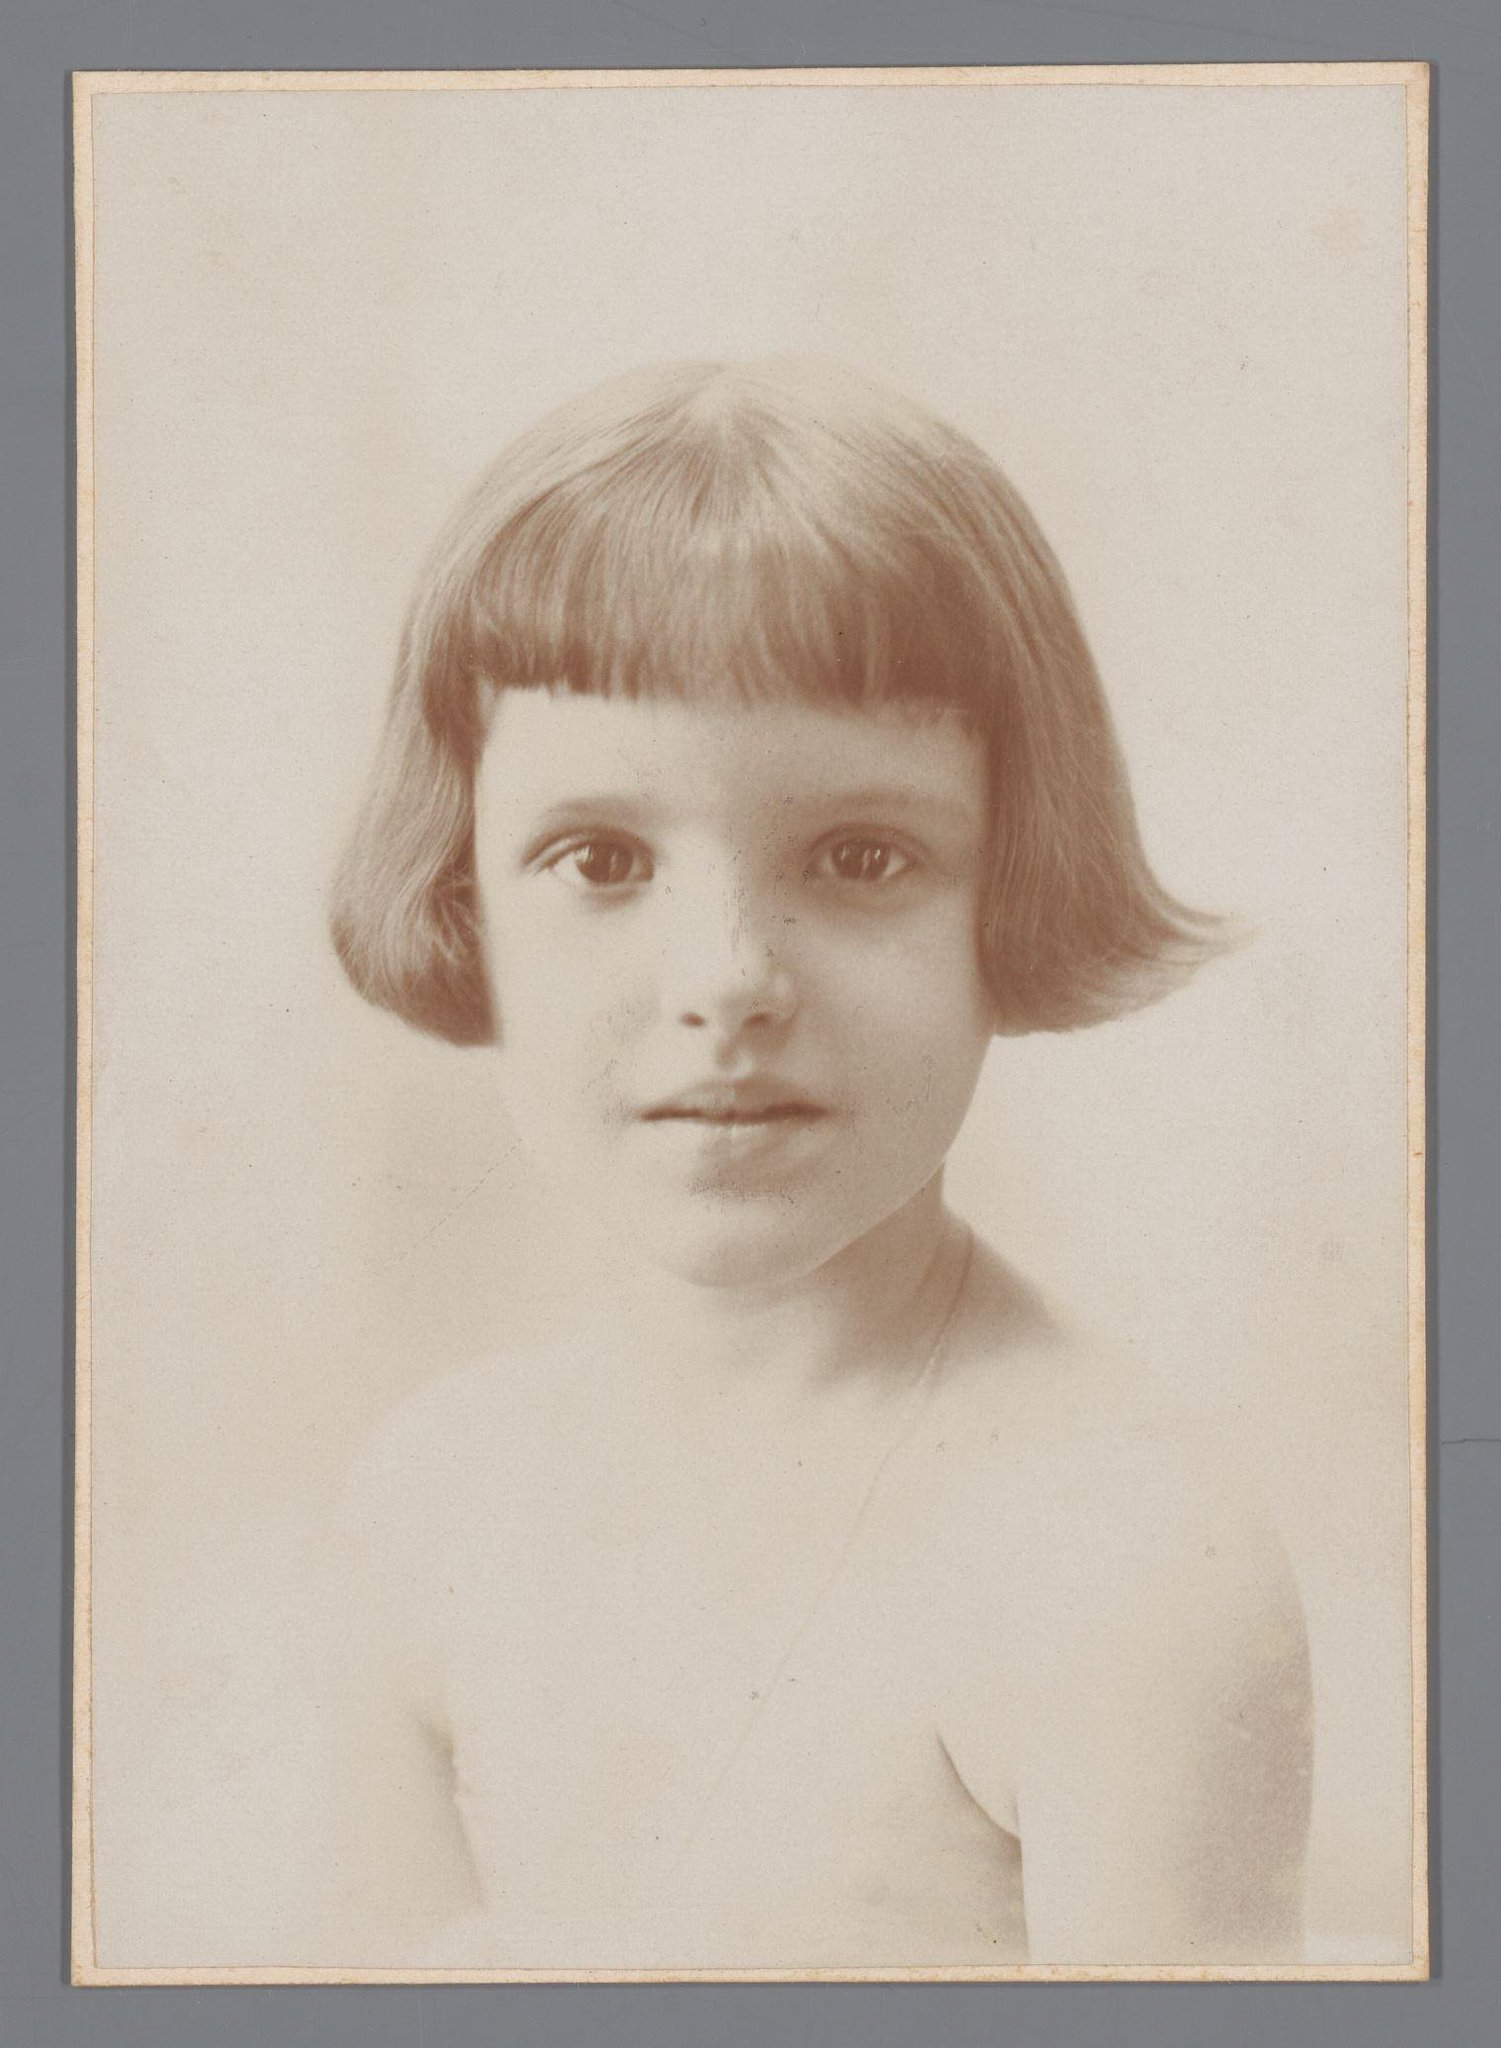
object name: photograph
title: Portret van naakt meisje en face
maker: Anonymous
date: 1900-1925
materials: cardboard, paper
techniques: gelatin silver print